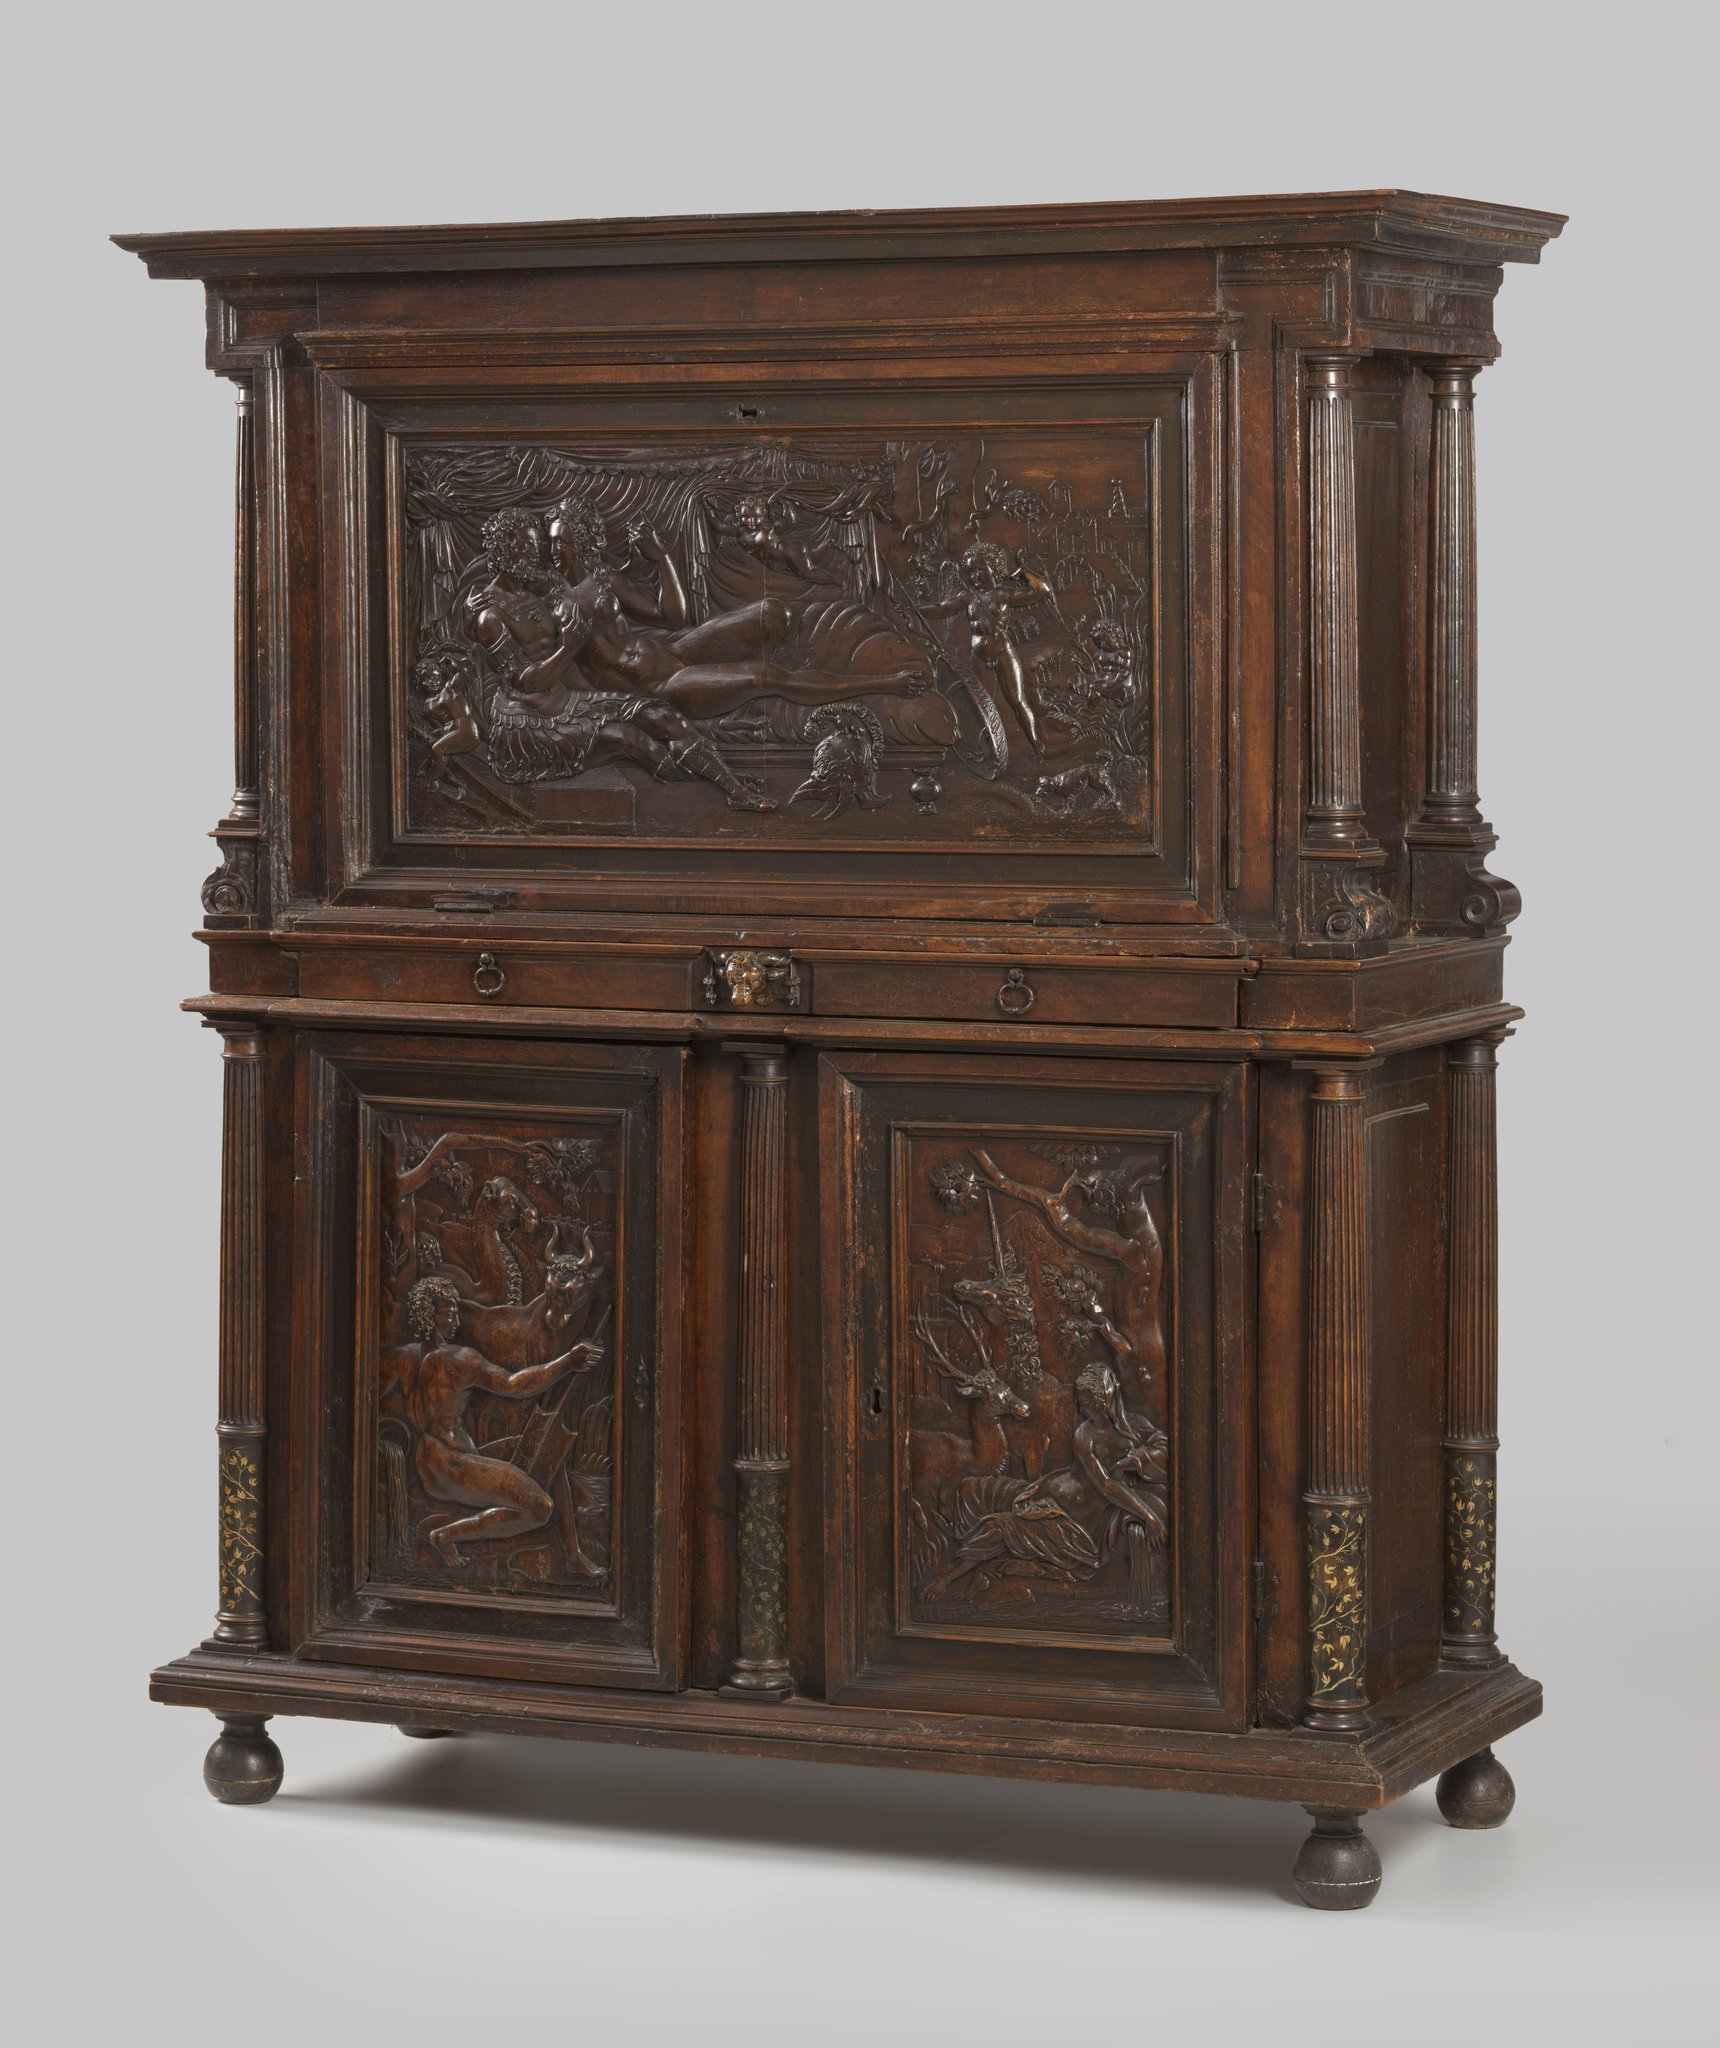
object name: desk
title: Schrijfkabinet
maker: Anonymous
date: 1550-1600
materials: silver, wood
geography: france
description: Schrijfkabinet van notenhout, verdeeld in onder- en bovenkast. De onderkast heeft op de hoekstijlen Toscaanse zuilen en op de middenstijl een halve Toscaanse zuil, wier schachten met bladranken beschilderd zijn. De twee deuren vertonen, in laag reliëf, voorstellingen met stroomgod- en godin, omringd door diverse dieren. In de fries boven de deuren bevinden zich twee laden. Het schrijfblad vertoont Mars en Venus, omgeven door cupido-figuren. Binnenin achtien laden rond boognis, met zilveren versierde platen.